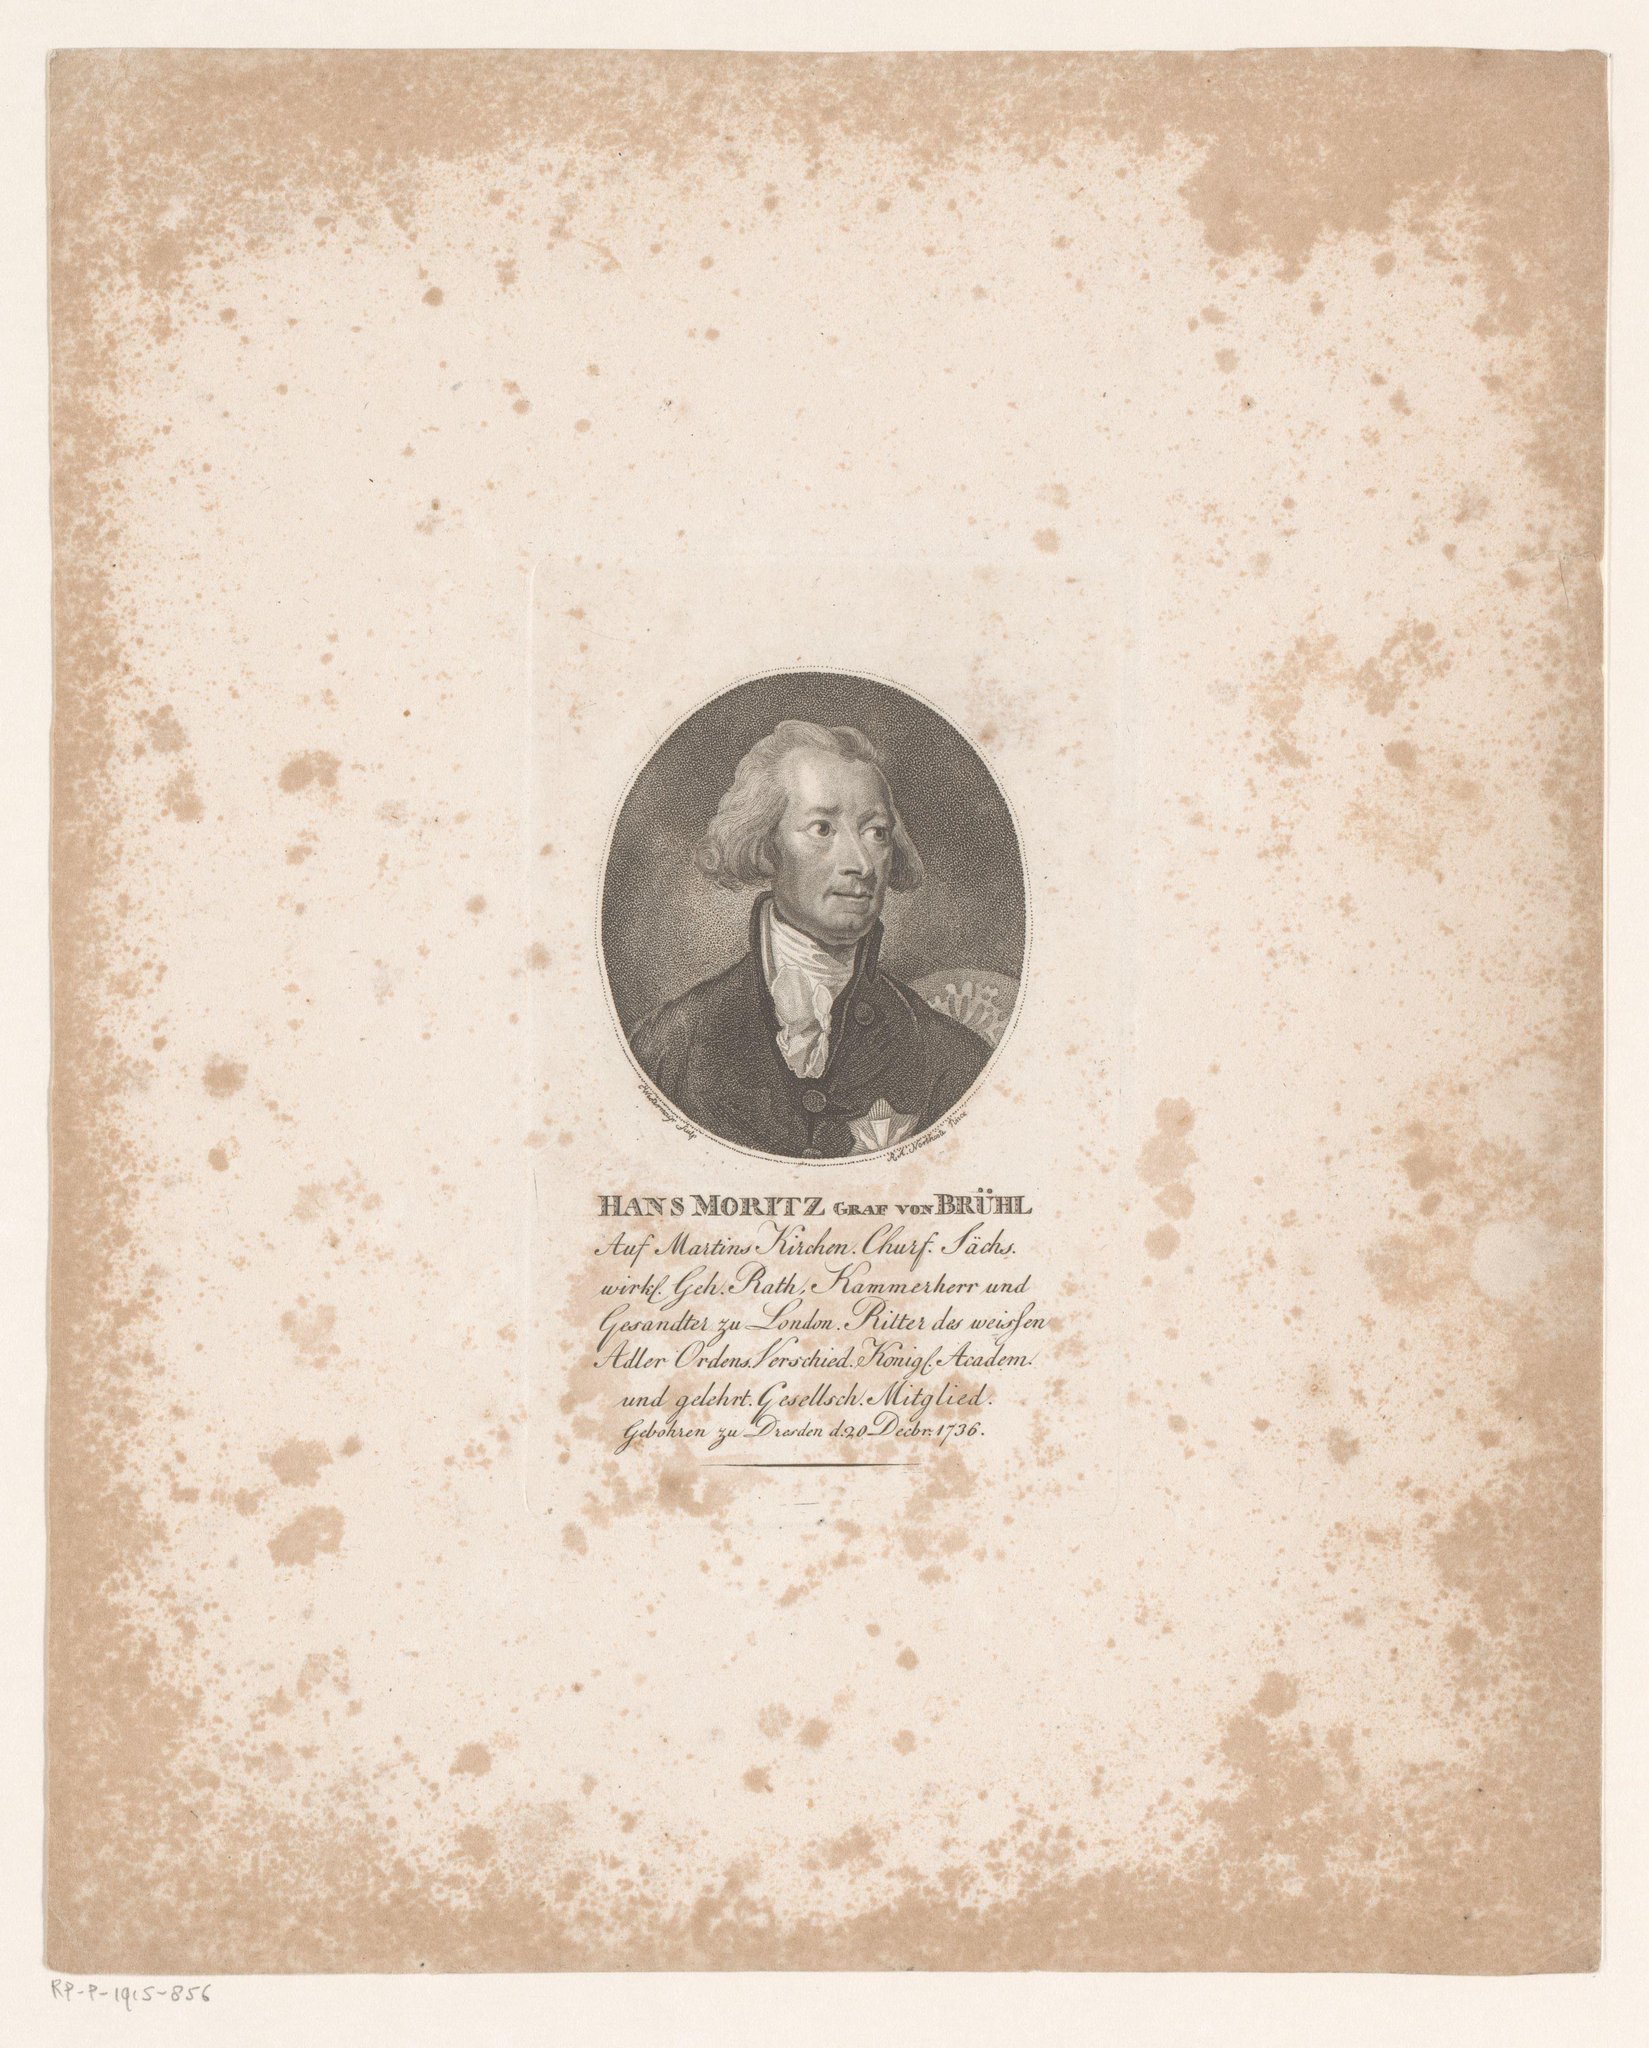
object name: print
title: Portret van Hans Moritz von Brühl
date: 1775-1834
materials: paper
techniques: engraving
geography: germany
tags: london, hans moritz von brühl, historical persons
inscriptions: collector's mark: Lugt 2228